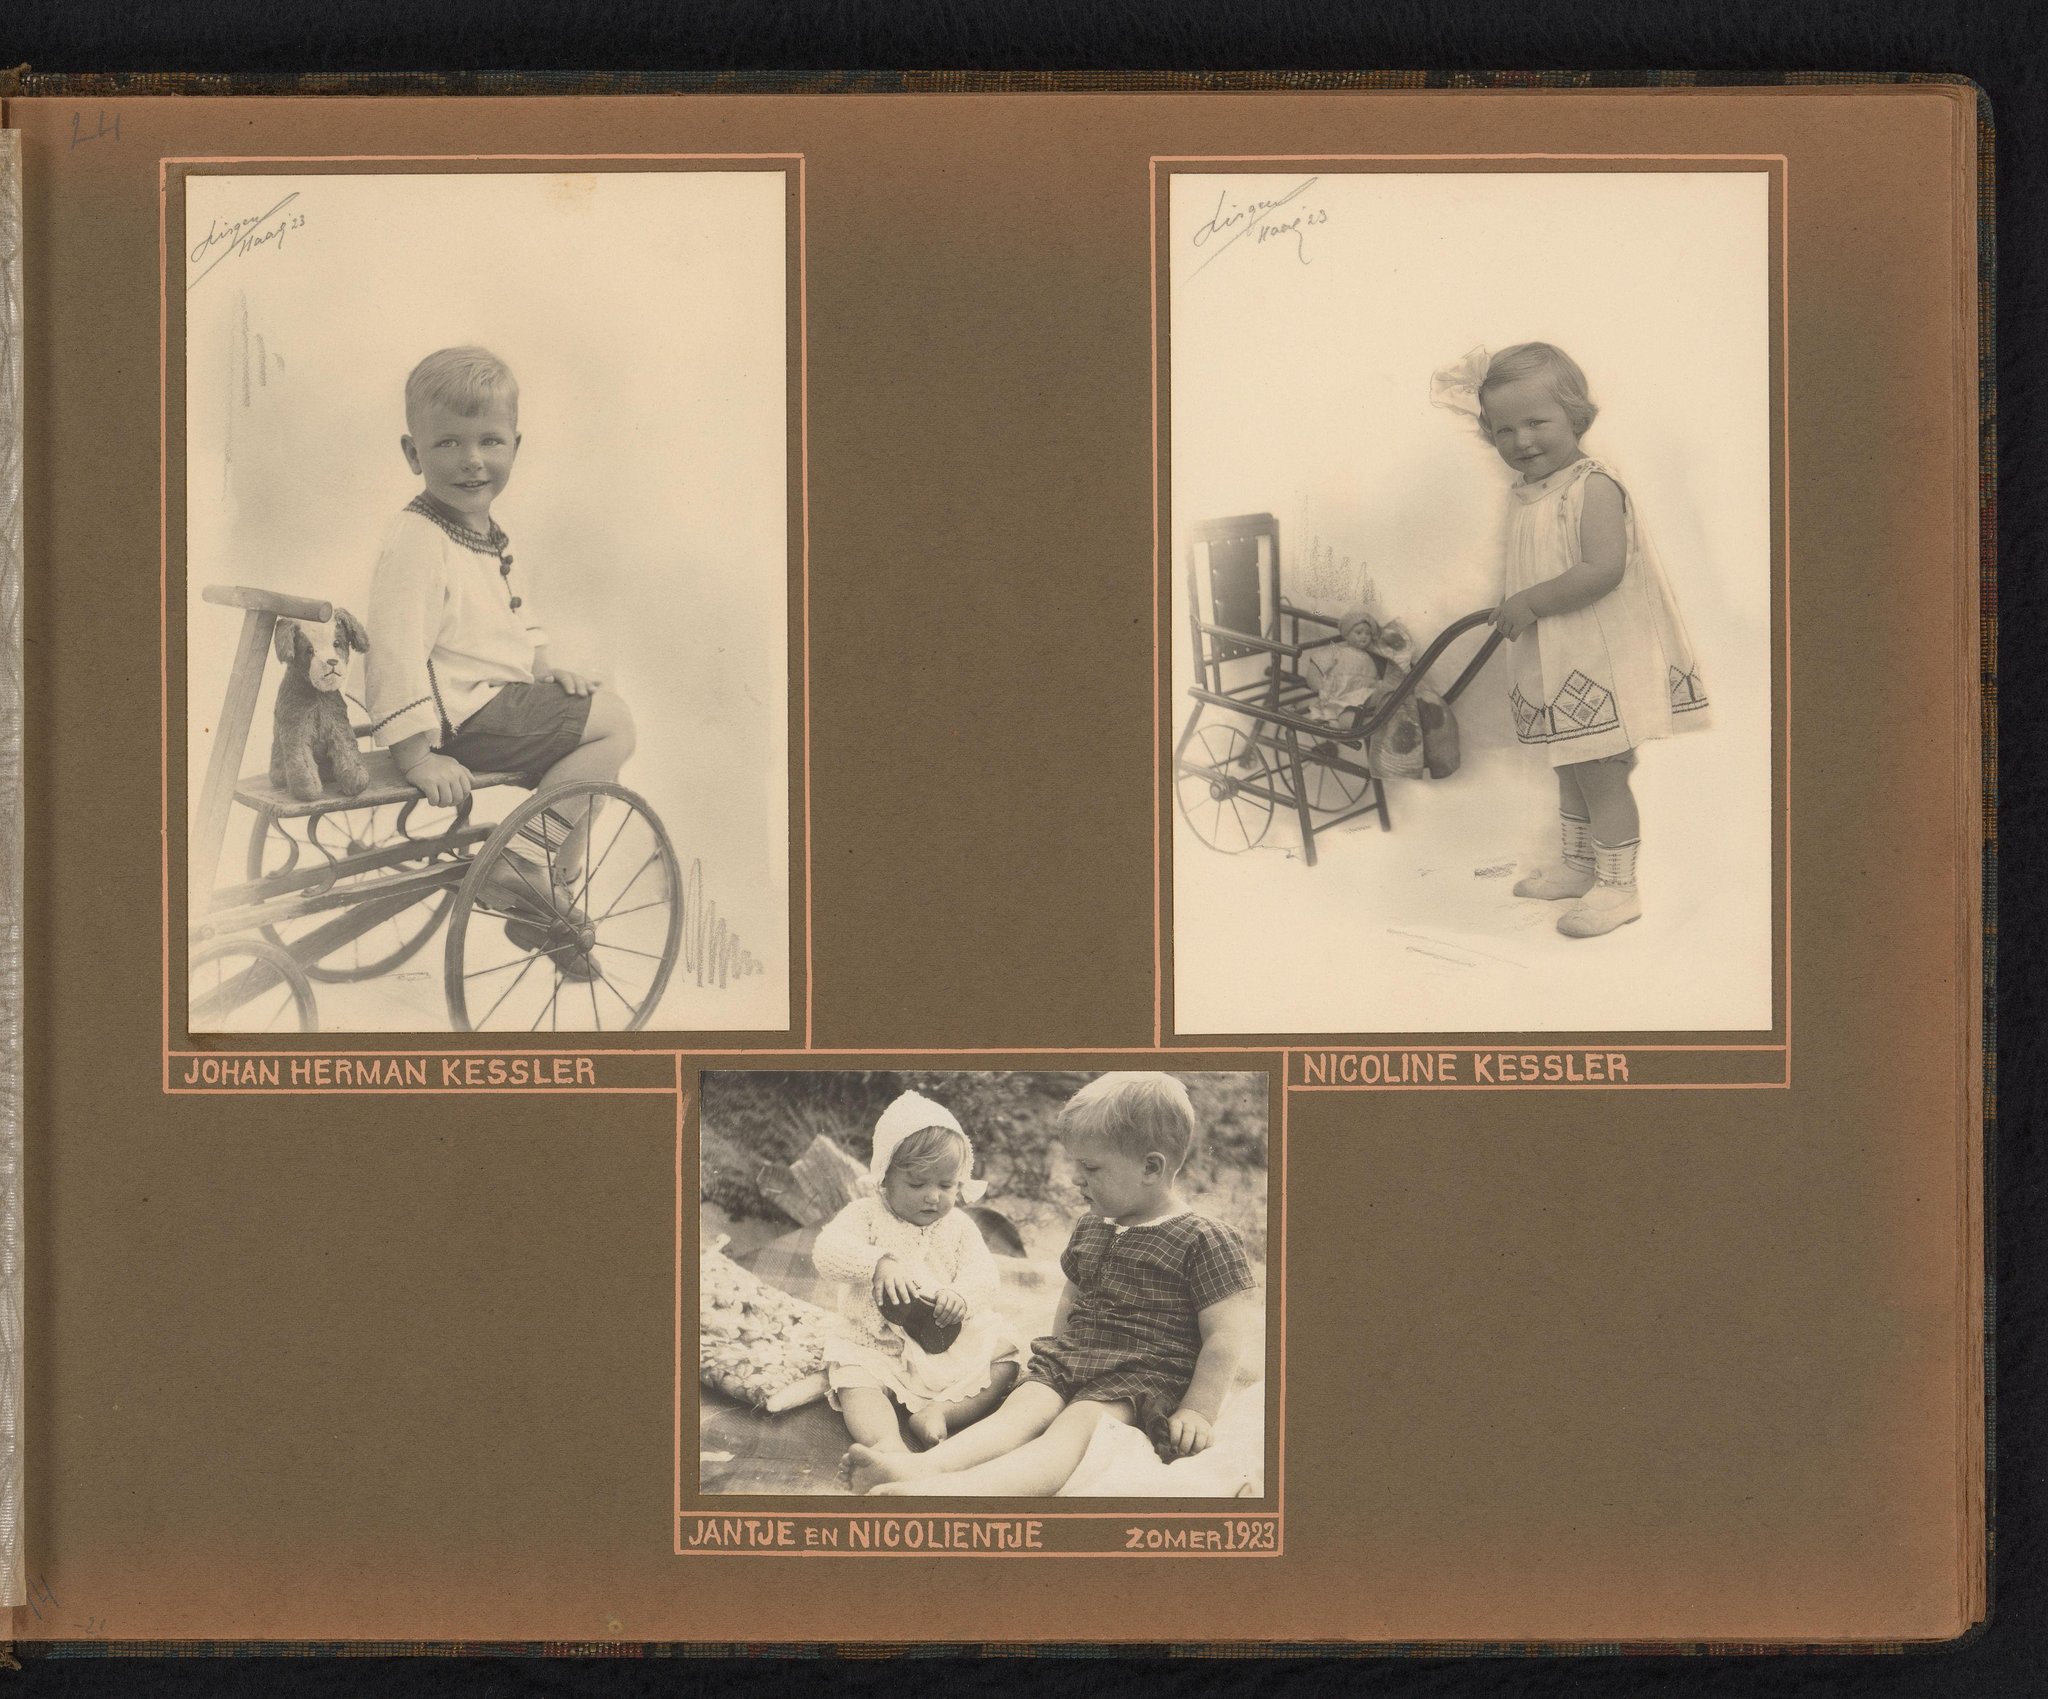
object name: photograph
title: Johan Herman Kessler, Nicoline Kessler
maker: Anonymous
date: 1923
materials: paper, cardboard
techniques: gelatin silver print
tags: johan herman kessler, historical persons